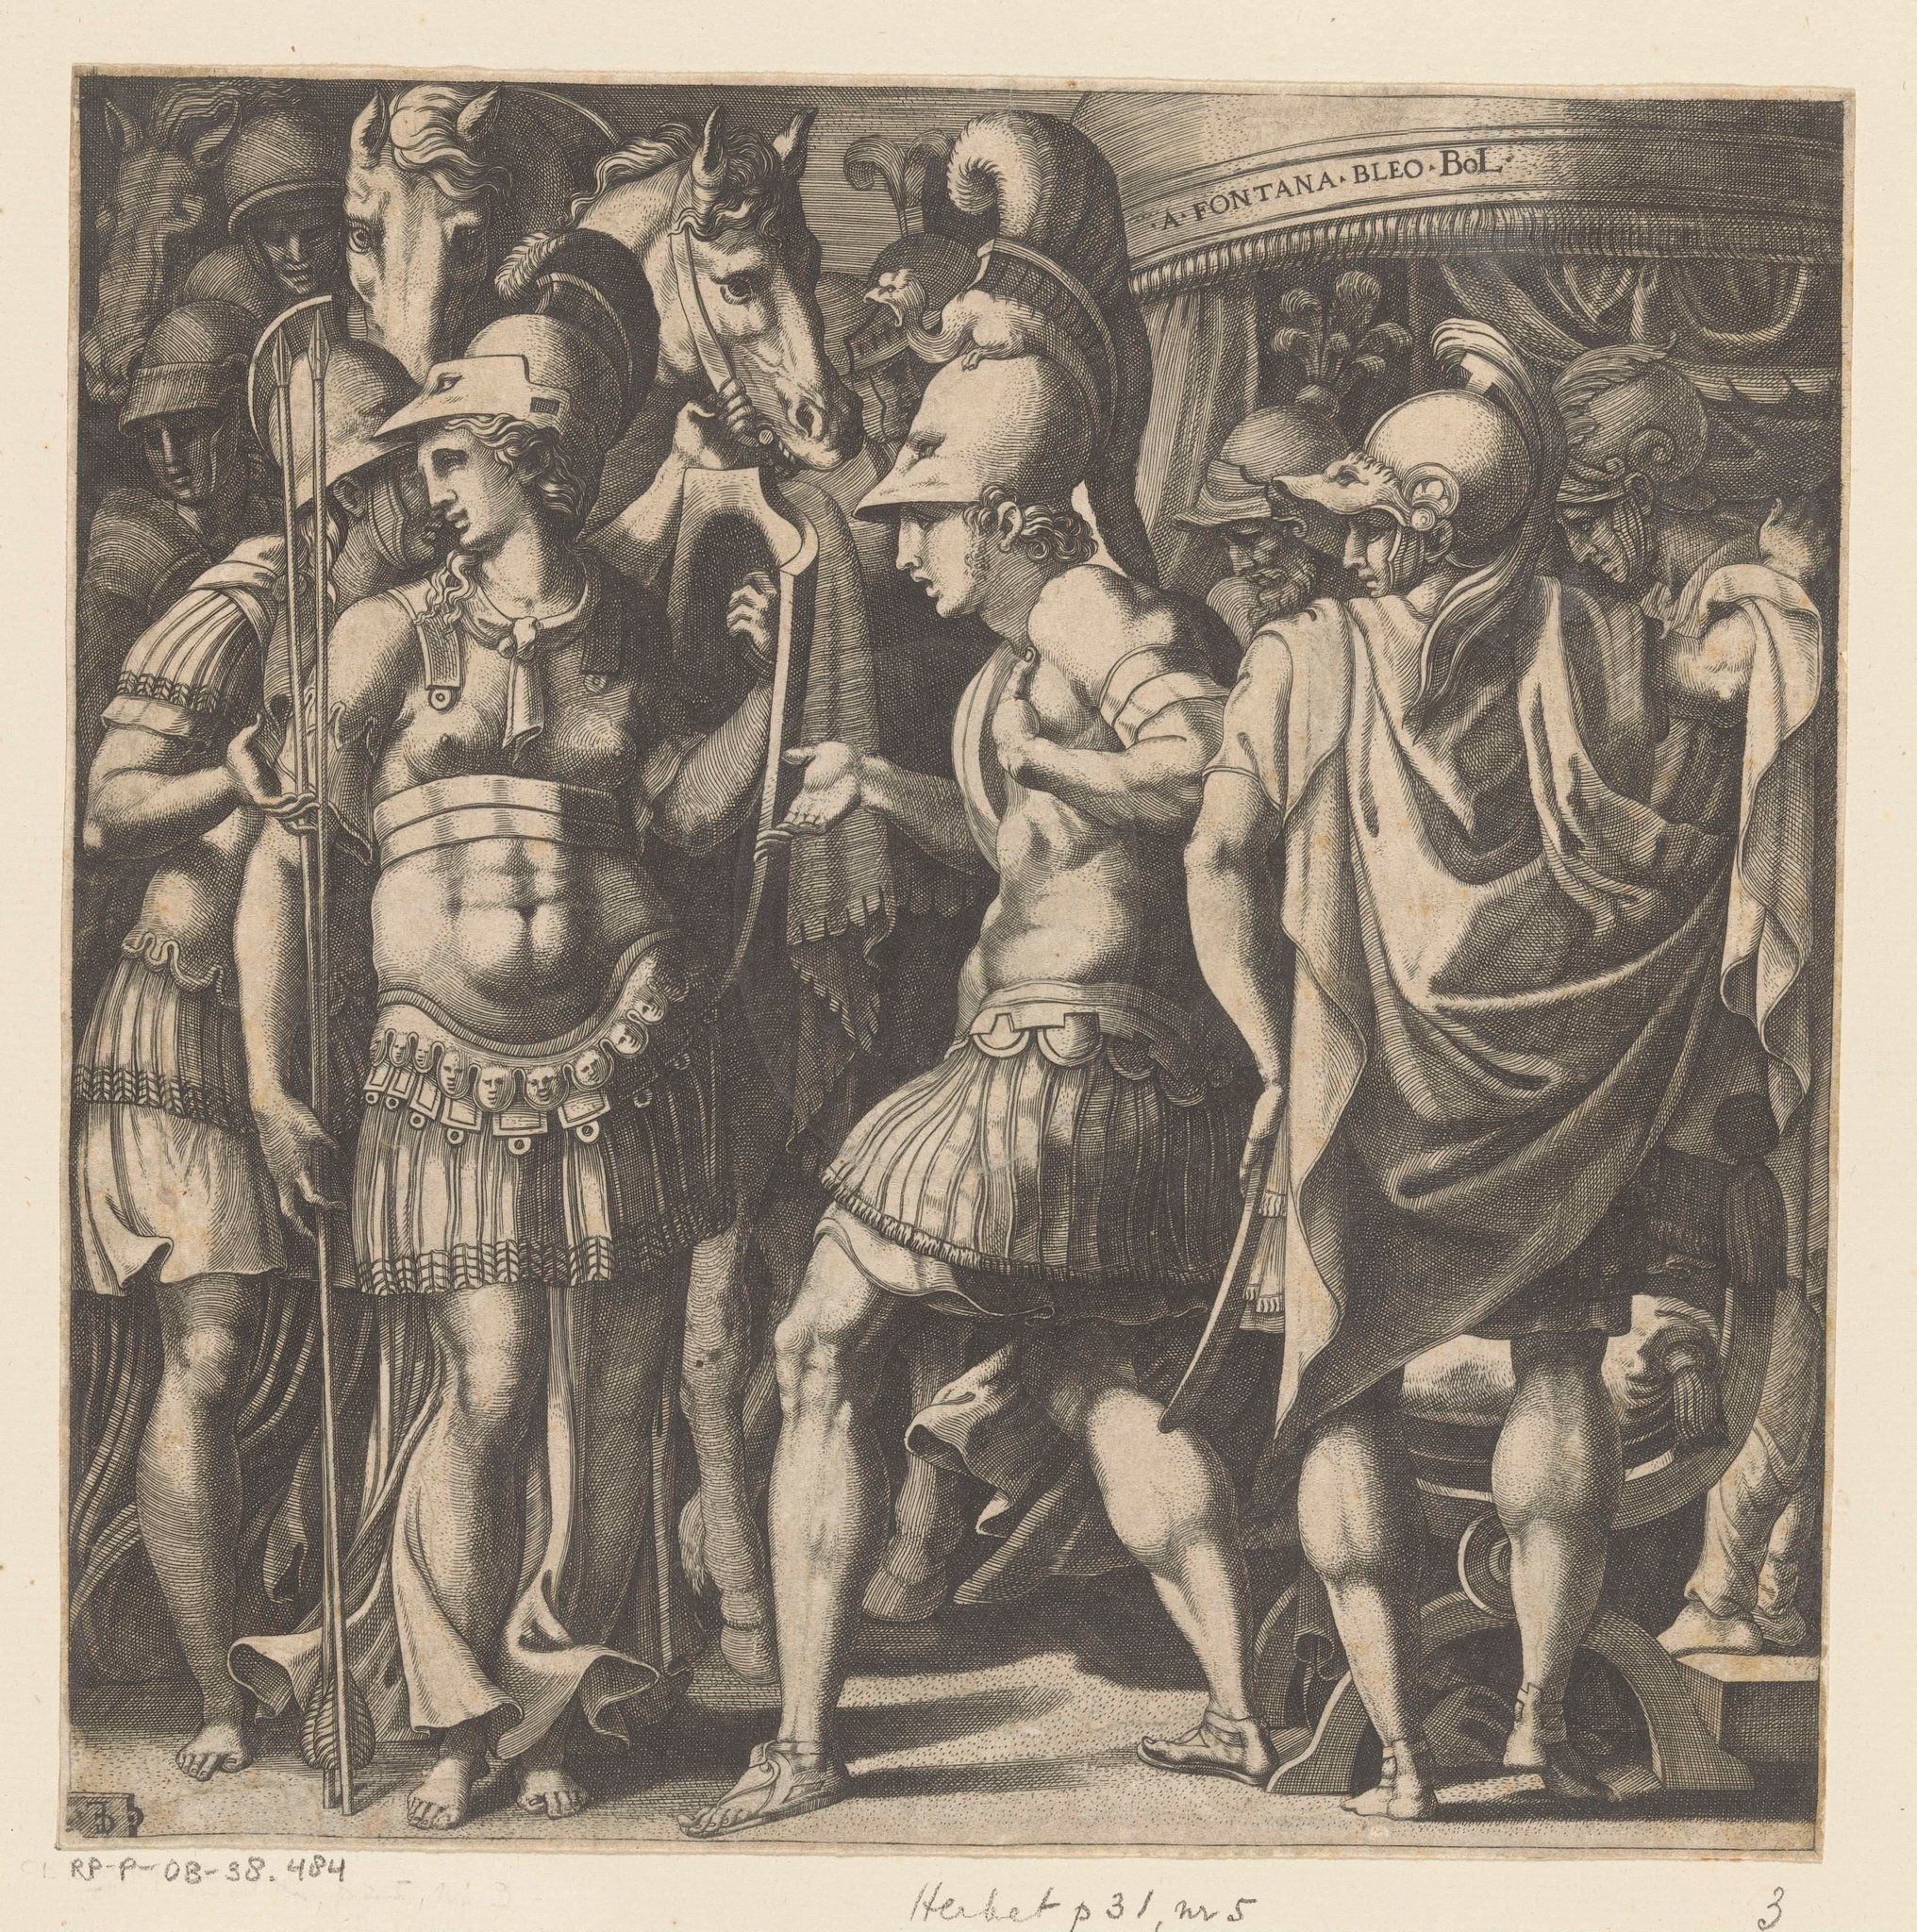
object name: print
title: Alexander ontvangt Talestris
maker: monogrammist fg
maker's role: print maker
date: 1529-1542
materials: paper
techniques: engraving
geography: italy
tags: (story of) the amazons, thalestris, queen of the amazons, comes to meet alexander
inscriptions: collector's mark: Lugt 240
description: Alexander de Grote, omgeven door mannelijke soldaten, is opgestaan uit zijn stoel en steekt zijn hand uit naar de amazone Talestris. Talestris wordt bijgestaan door amazones.